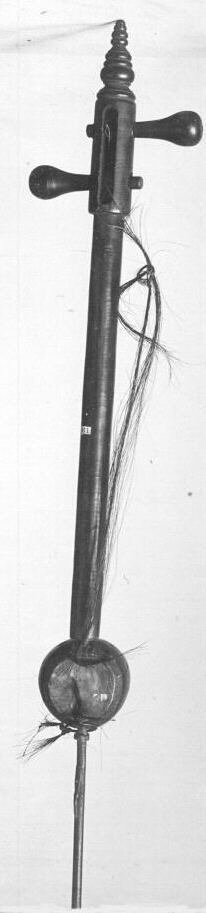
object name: kamānja agūz old fiddle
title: Kamānja agūz (old fiddle)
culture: arabian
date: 1867-1900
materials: plant material, skin, wood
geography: arabia